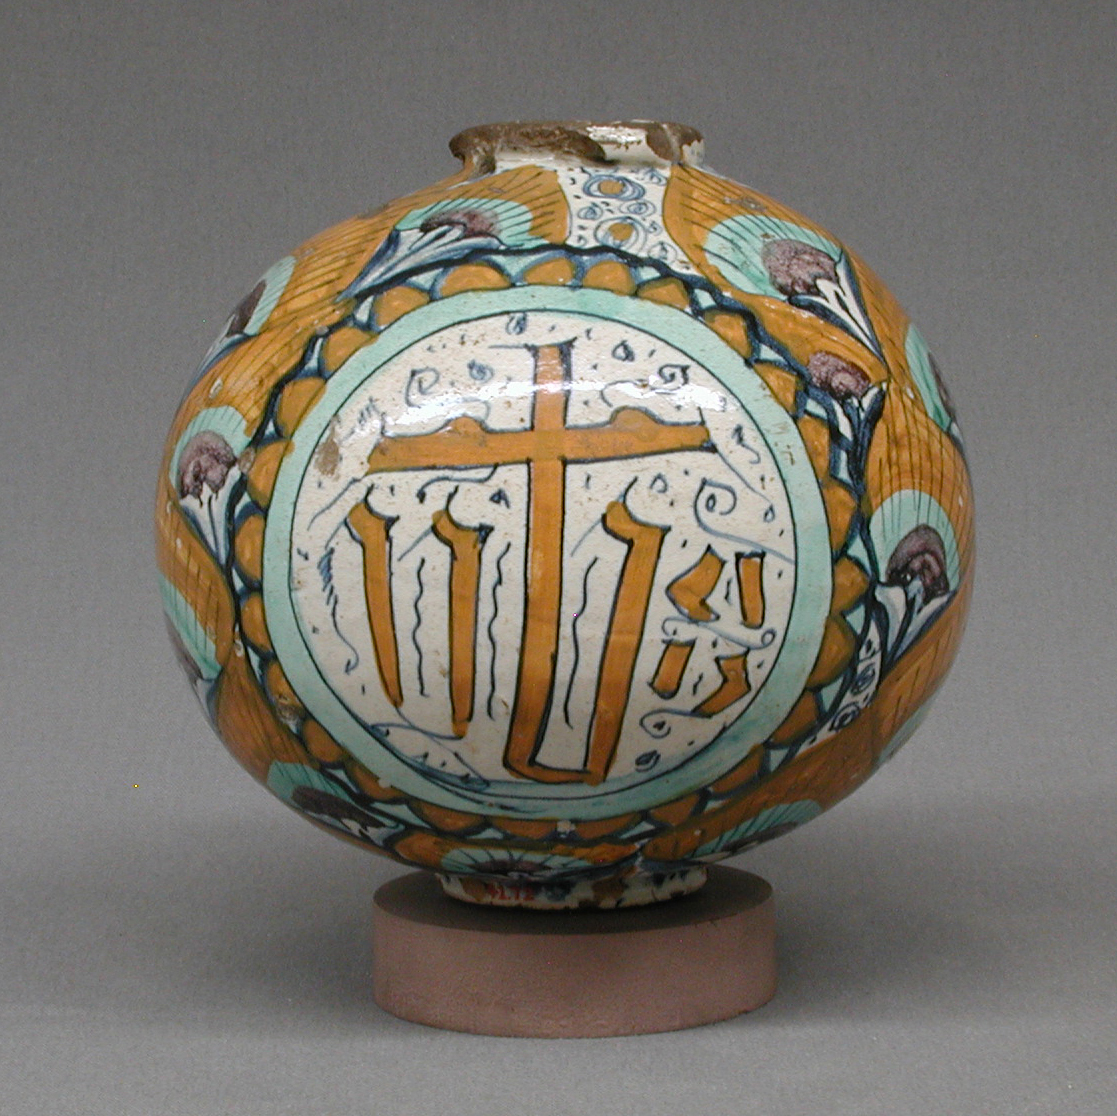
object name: globe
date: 1401-1500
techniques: maiolica, glazing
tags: globes